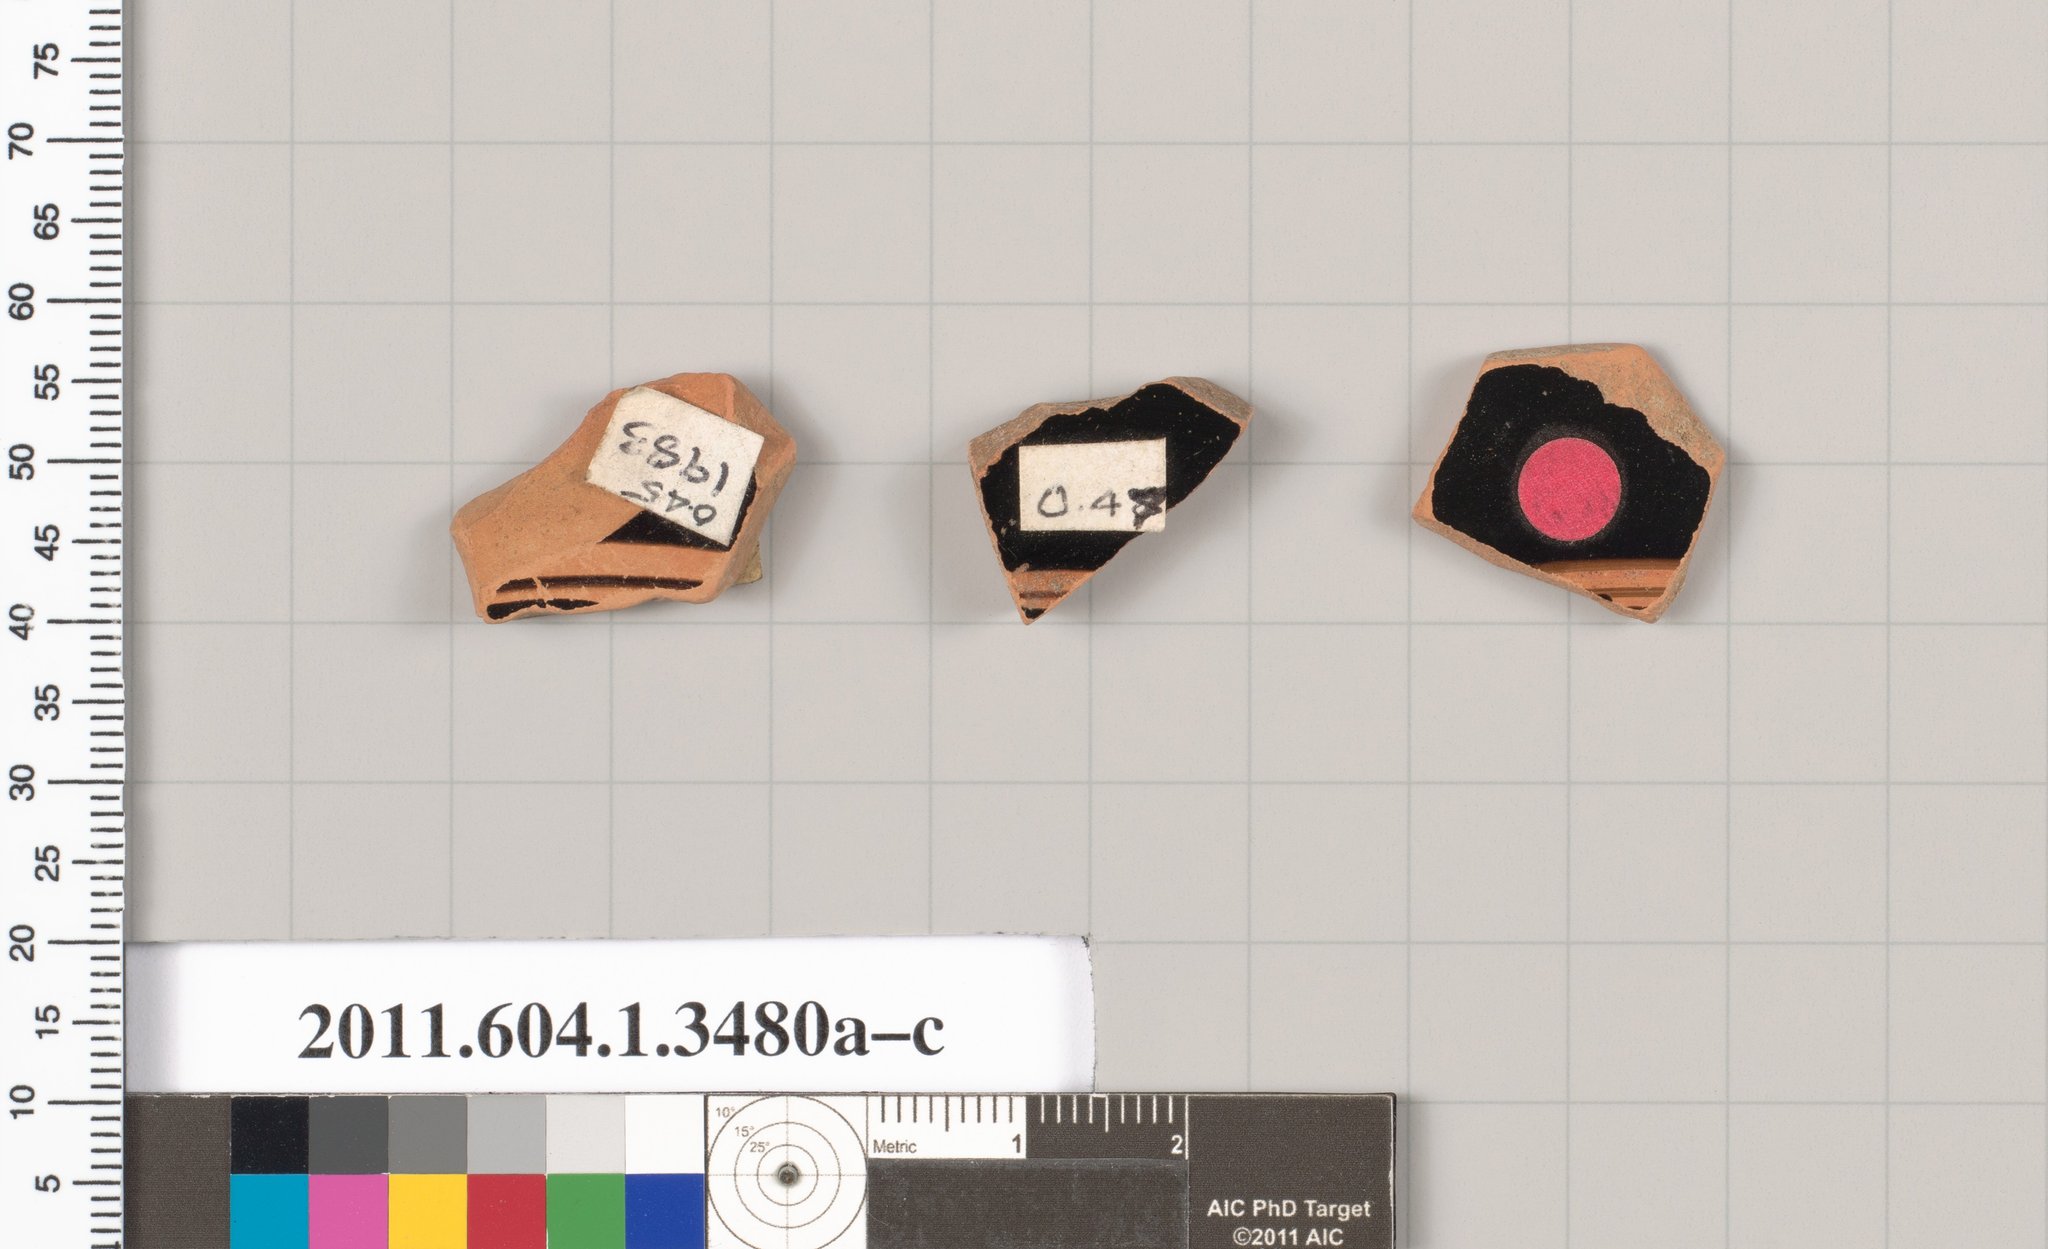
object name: kylix fragment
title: Terracotta fragments of kylikes (drinking cups)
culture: greek, attic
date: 500-475 BCE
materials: terracotta